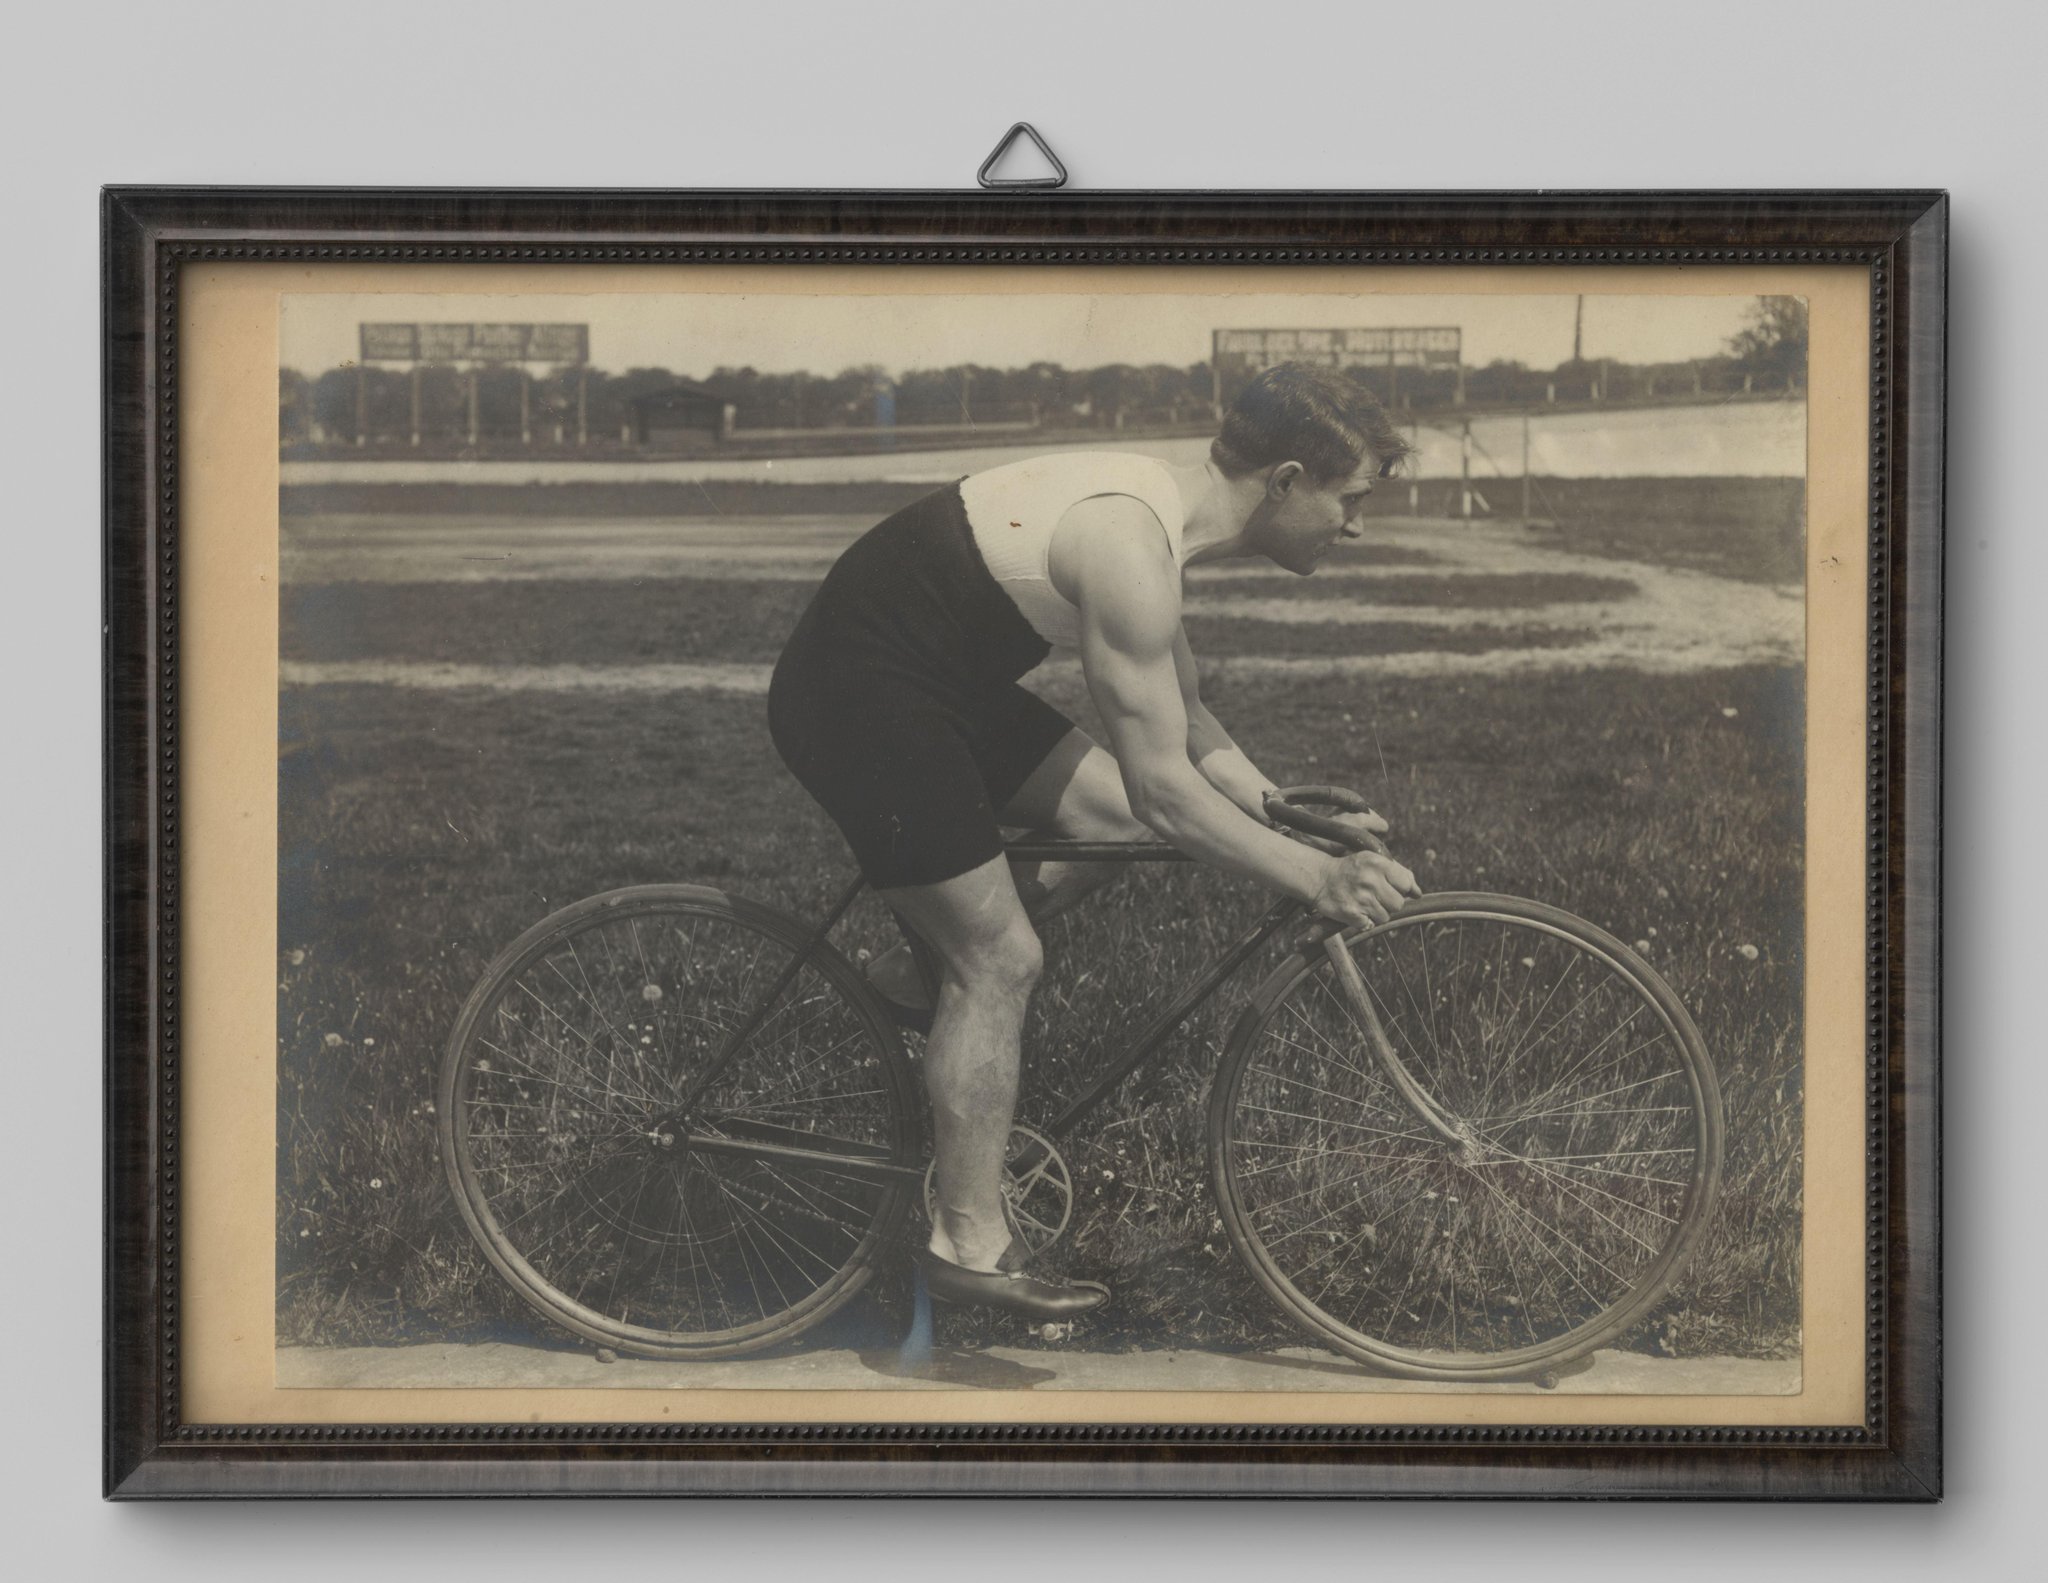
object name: photograph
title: Portret van John Stol op de fiets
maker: Anonymous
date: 1900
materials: paper, cardboard, glass, metal, wood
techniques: gelatin silver print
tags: bicycle racing, historical persons, bicycle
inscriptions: inscription: ‘+/- 1900/ JOHN STOL’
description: Portret van de Nederlandse baanwielrenner John Stol.